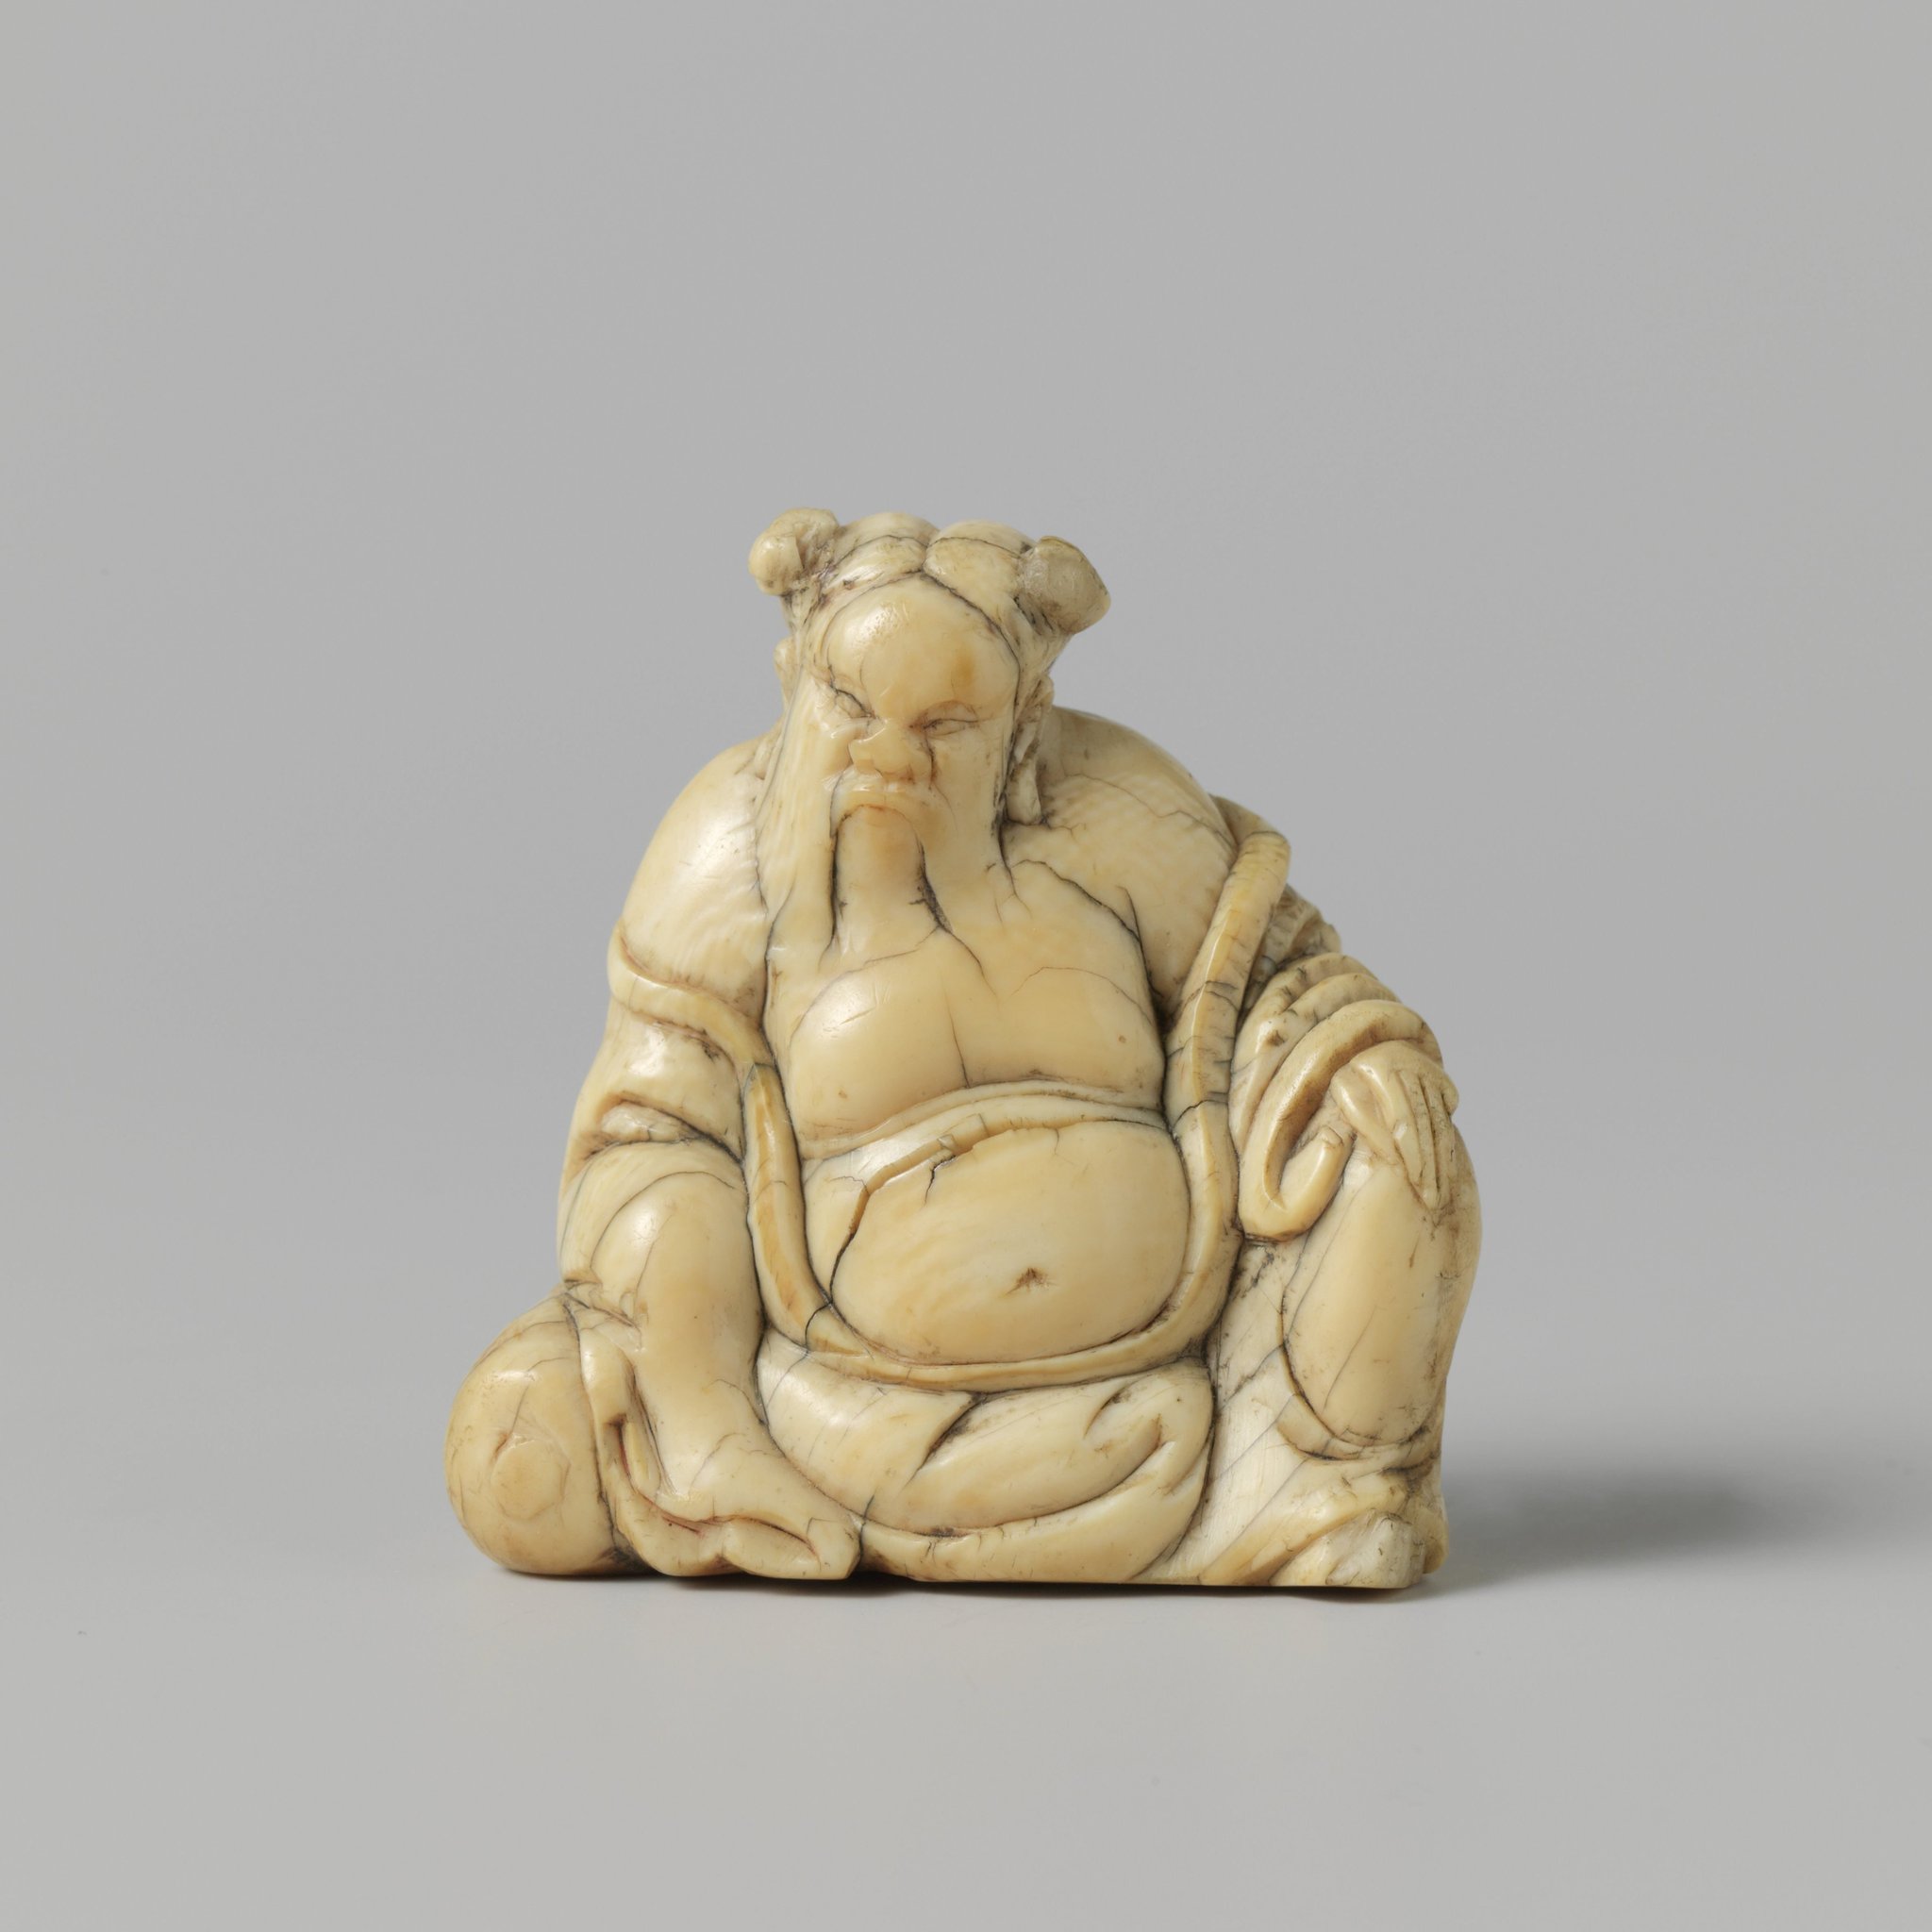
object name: figure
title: Budai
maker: Anonymous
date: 1600-1699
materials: ivory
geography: china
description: Budai (literally ‘sack cloth’) is a character from Chinese folklore. He can be identified from his sack and his bare, fat belly. Budai represents contentment.